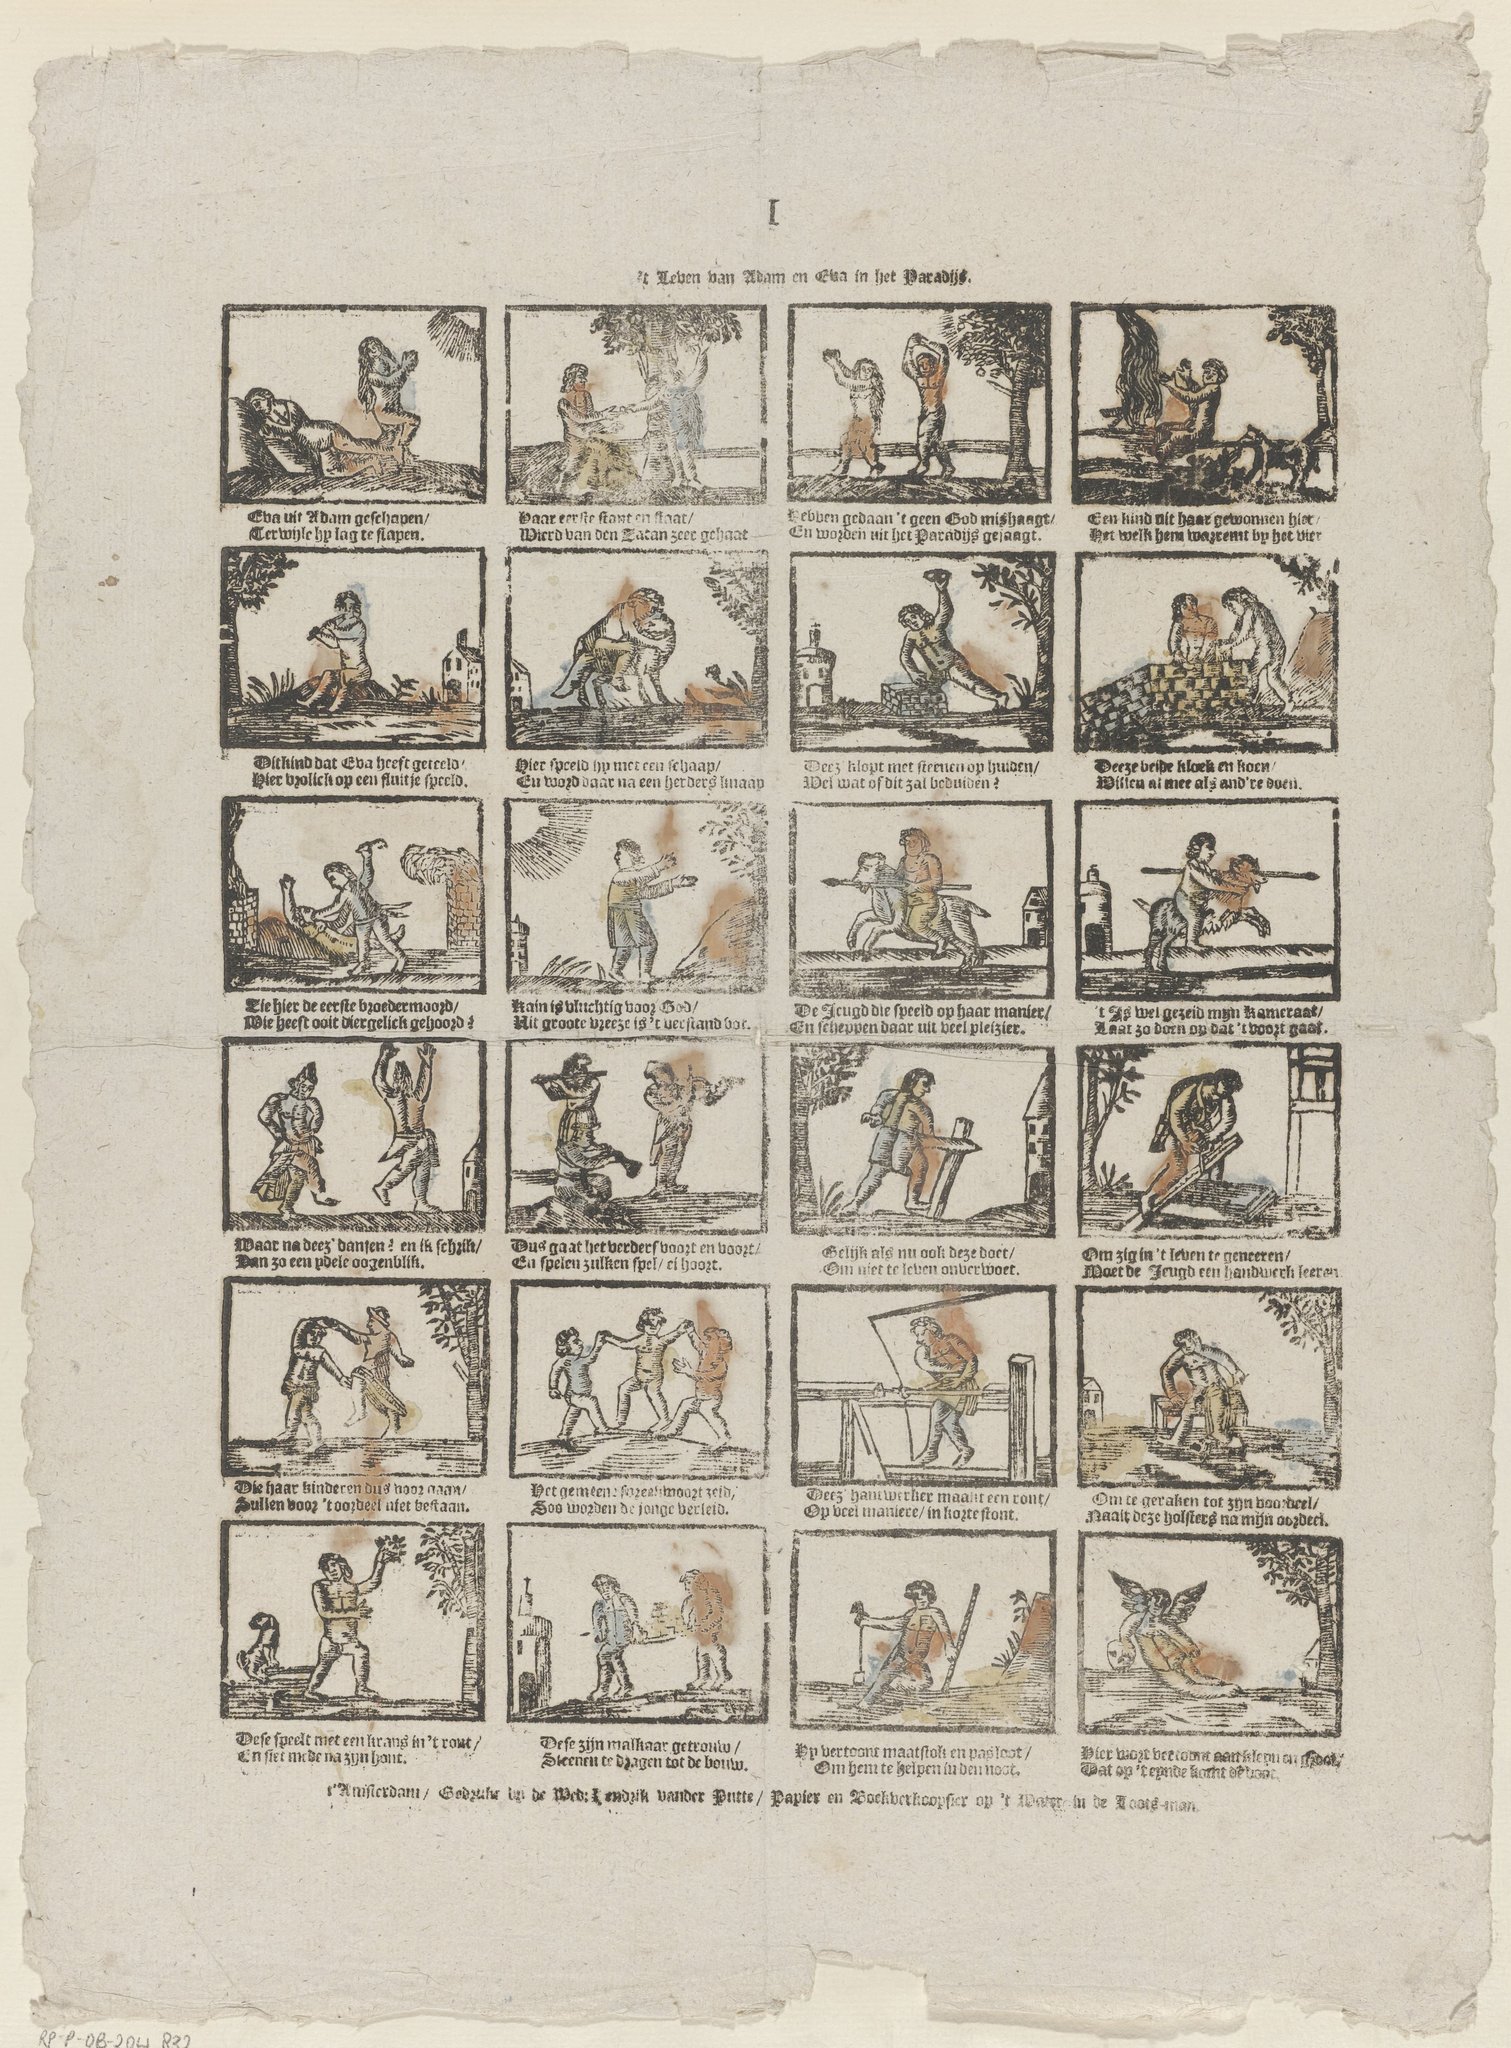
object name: print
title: 't Leven van Adam en Eva in het paradijs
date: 1765-1767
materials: paper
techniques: colour, letterpress printing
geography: amsterdam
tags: craft-production, skilled handiwork, children's games and plays, old testament, crafts and industries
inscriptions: collector's mark: Lugt 2760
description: Blad met 24 voorstellingen van verhalen uit het Nieuwe Testament en van kinderspelen en ambachtslieden. Onder elke afbeelding een tweeregelig vers. Genummerd midden boven: 1.